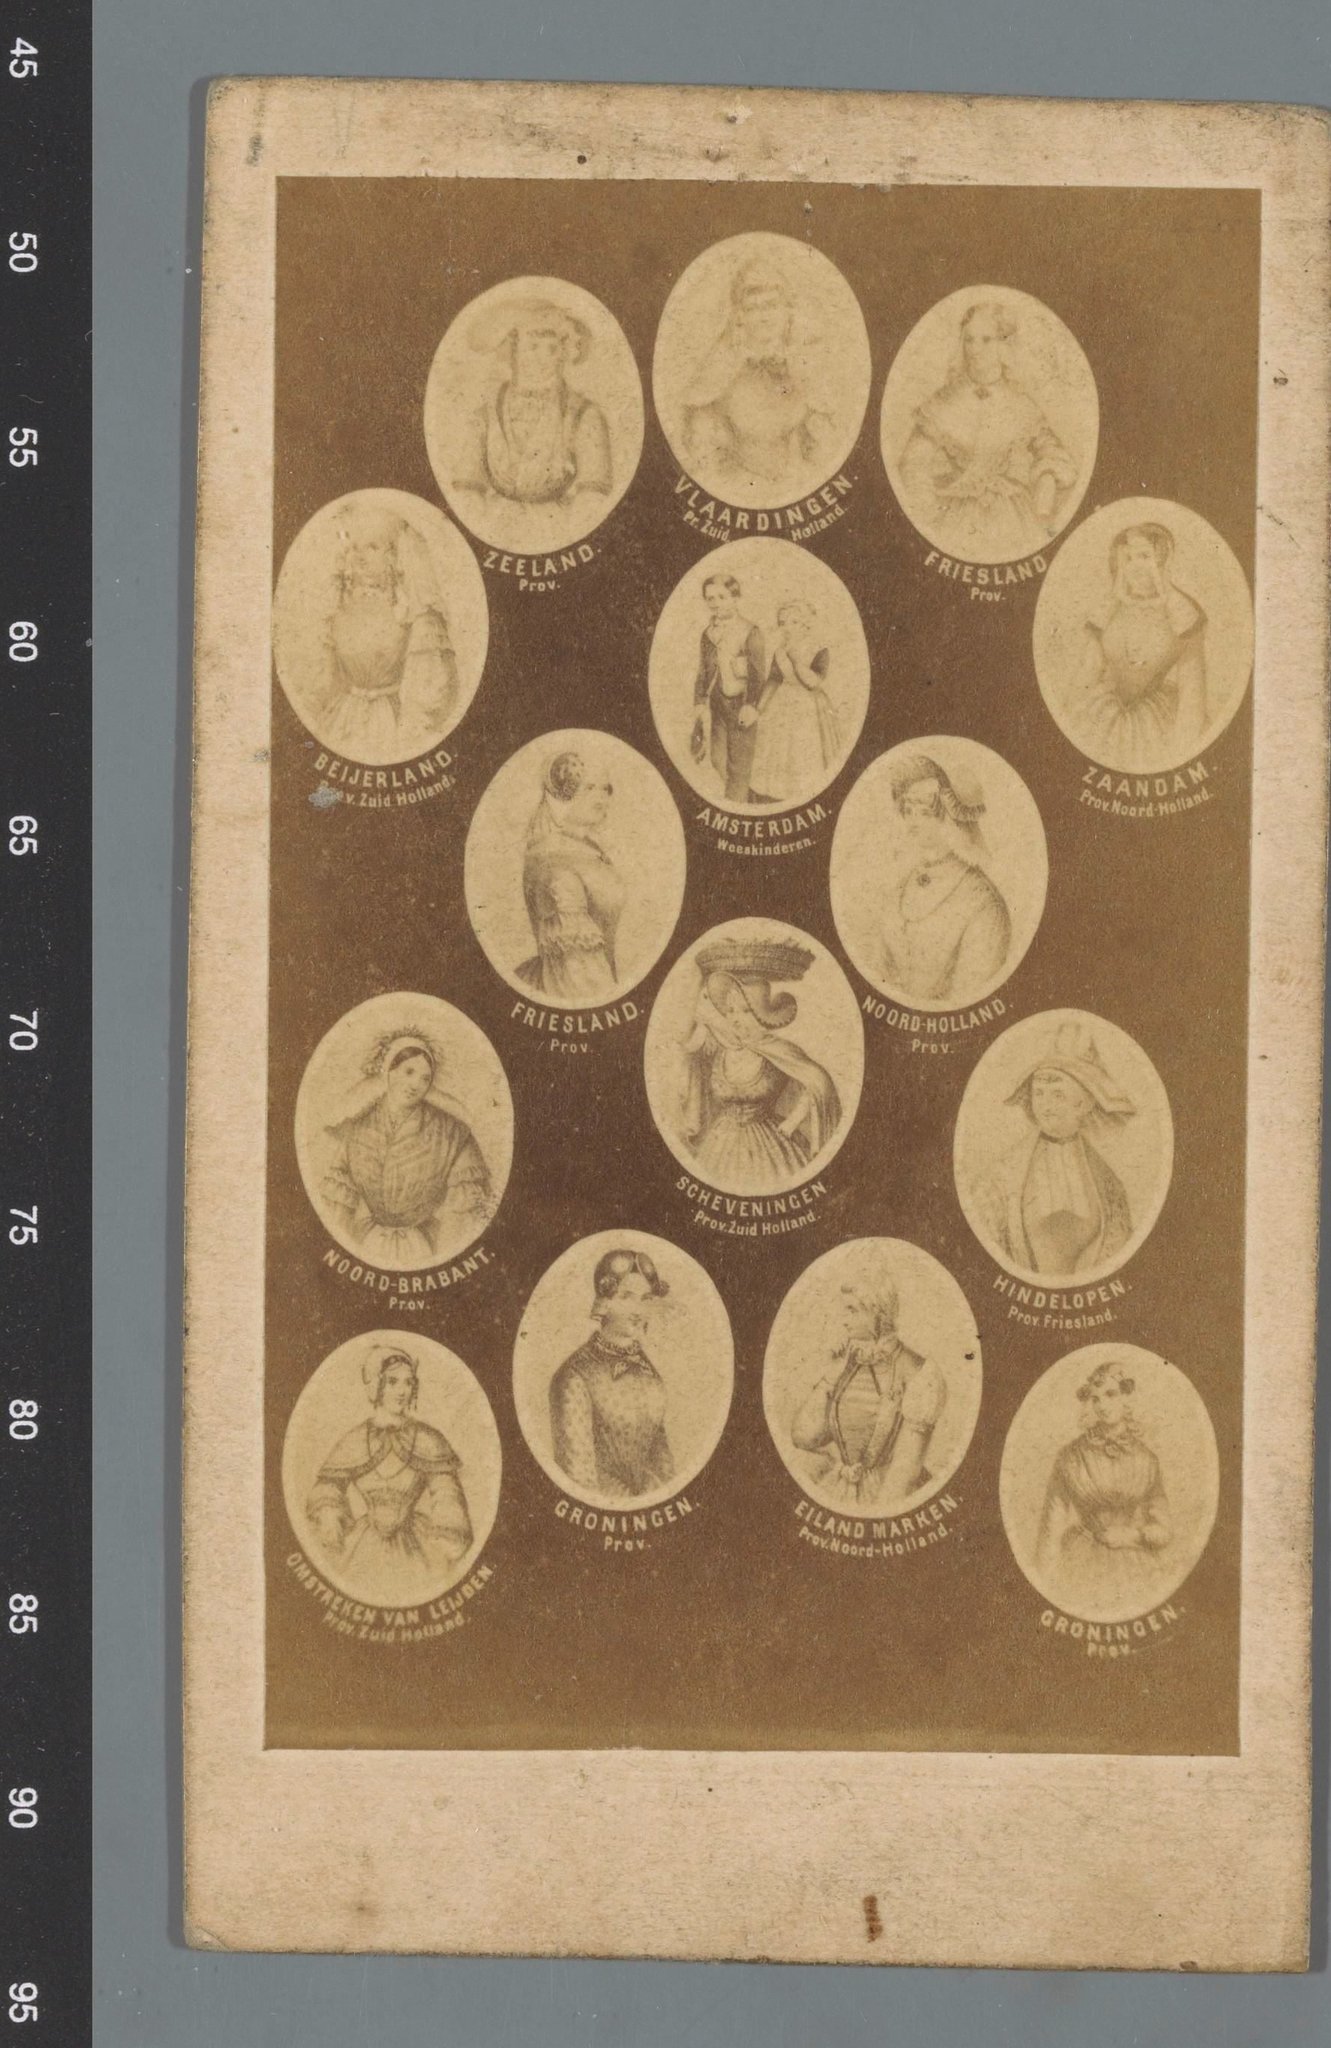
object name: carte de visite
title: Compositie van veertien afbeeldingen van Nederlandse klederdrachten, inclusief twee Amsterdamse weeskinderen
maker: Anonymous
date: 1865-1880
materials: cardboard, paper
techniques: albumen print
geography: netherlands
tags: folk costume, regional costume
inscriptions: inscription: ‘Hendriks’